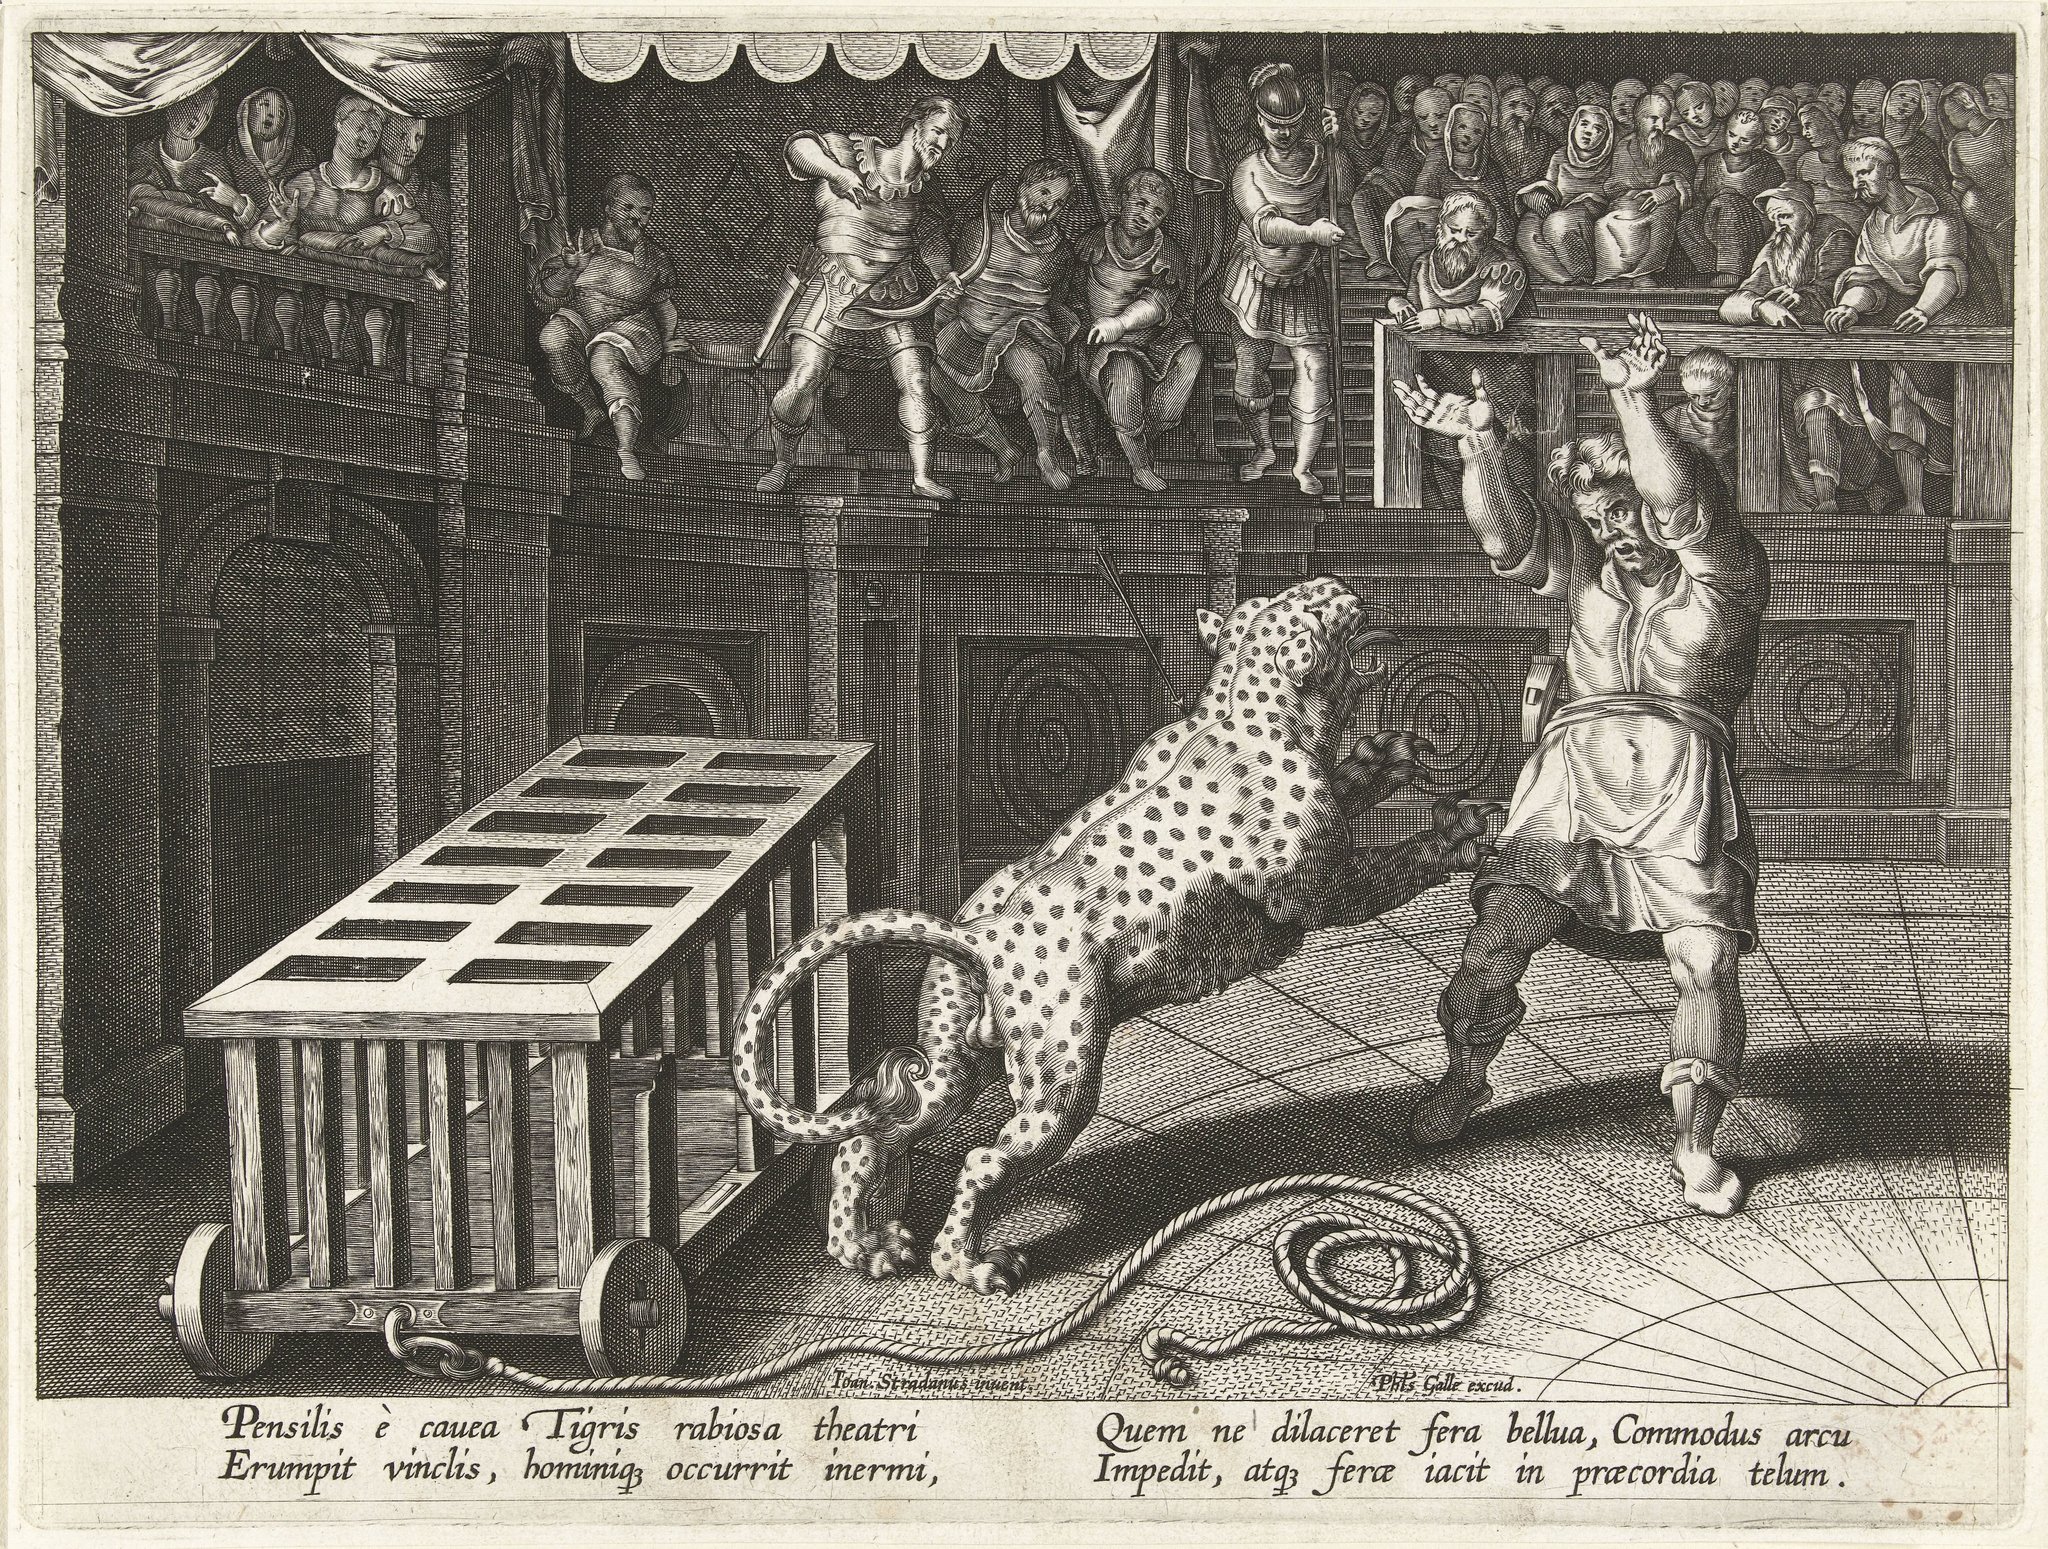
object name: print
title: Jachttaferelen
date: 1594-1598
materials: paper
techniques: engraving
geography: antwerp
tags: beasts of prey, predatory animals: leopard, archer's weapons: bow, (story of) commodus the roman emperor, circus ring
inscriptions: collector's mark: Lugt 240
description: De arena van een colosseum. Een luipaard breekt uit zijn kooi en valt een man aan. Keizer Commodus schiet met een boog een pijl in de borst van het beest. De prent heeft een Latijns onderschrift en is deel van een serie over jachttaferelen.